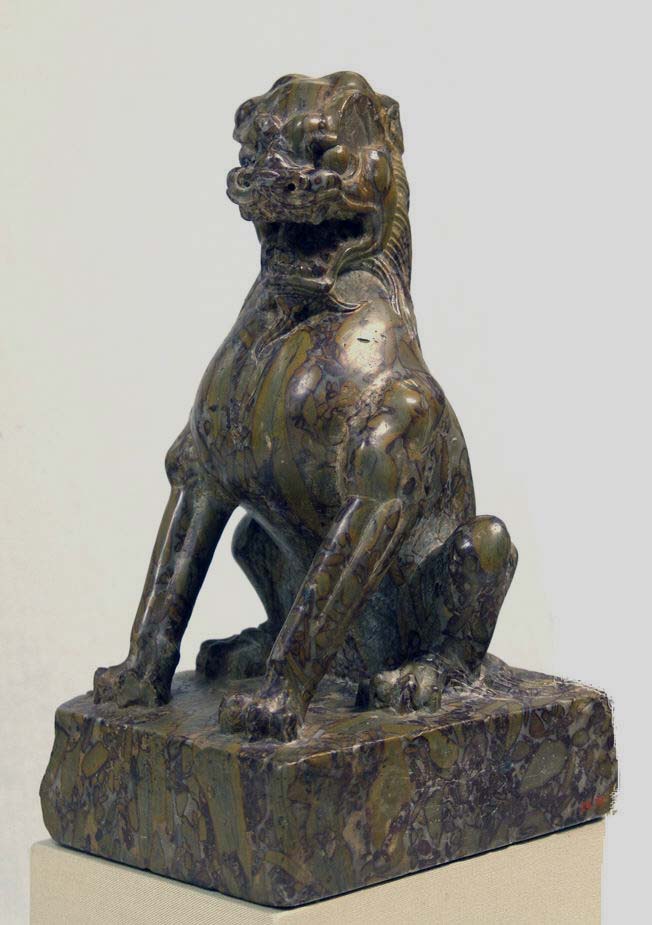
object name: figure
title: Seated Lion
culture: chinese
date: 701-800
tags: lions